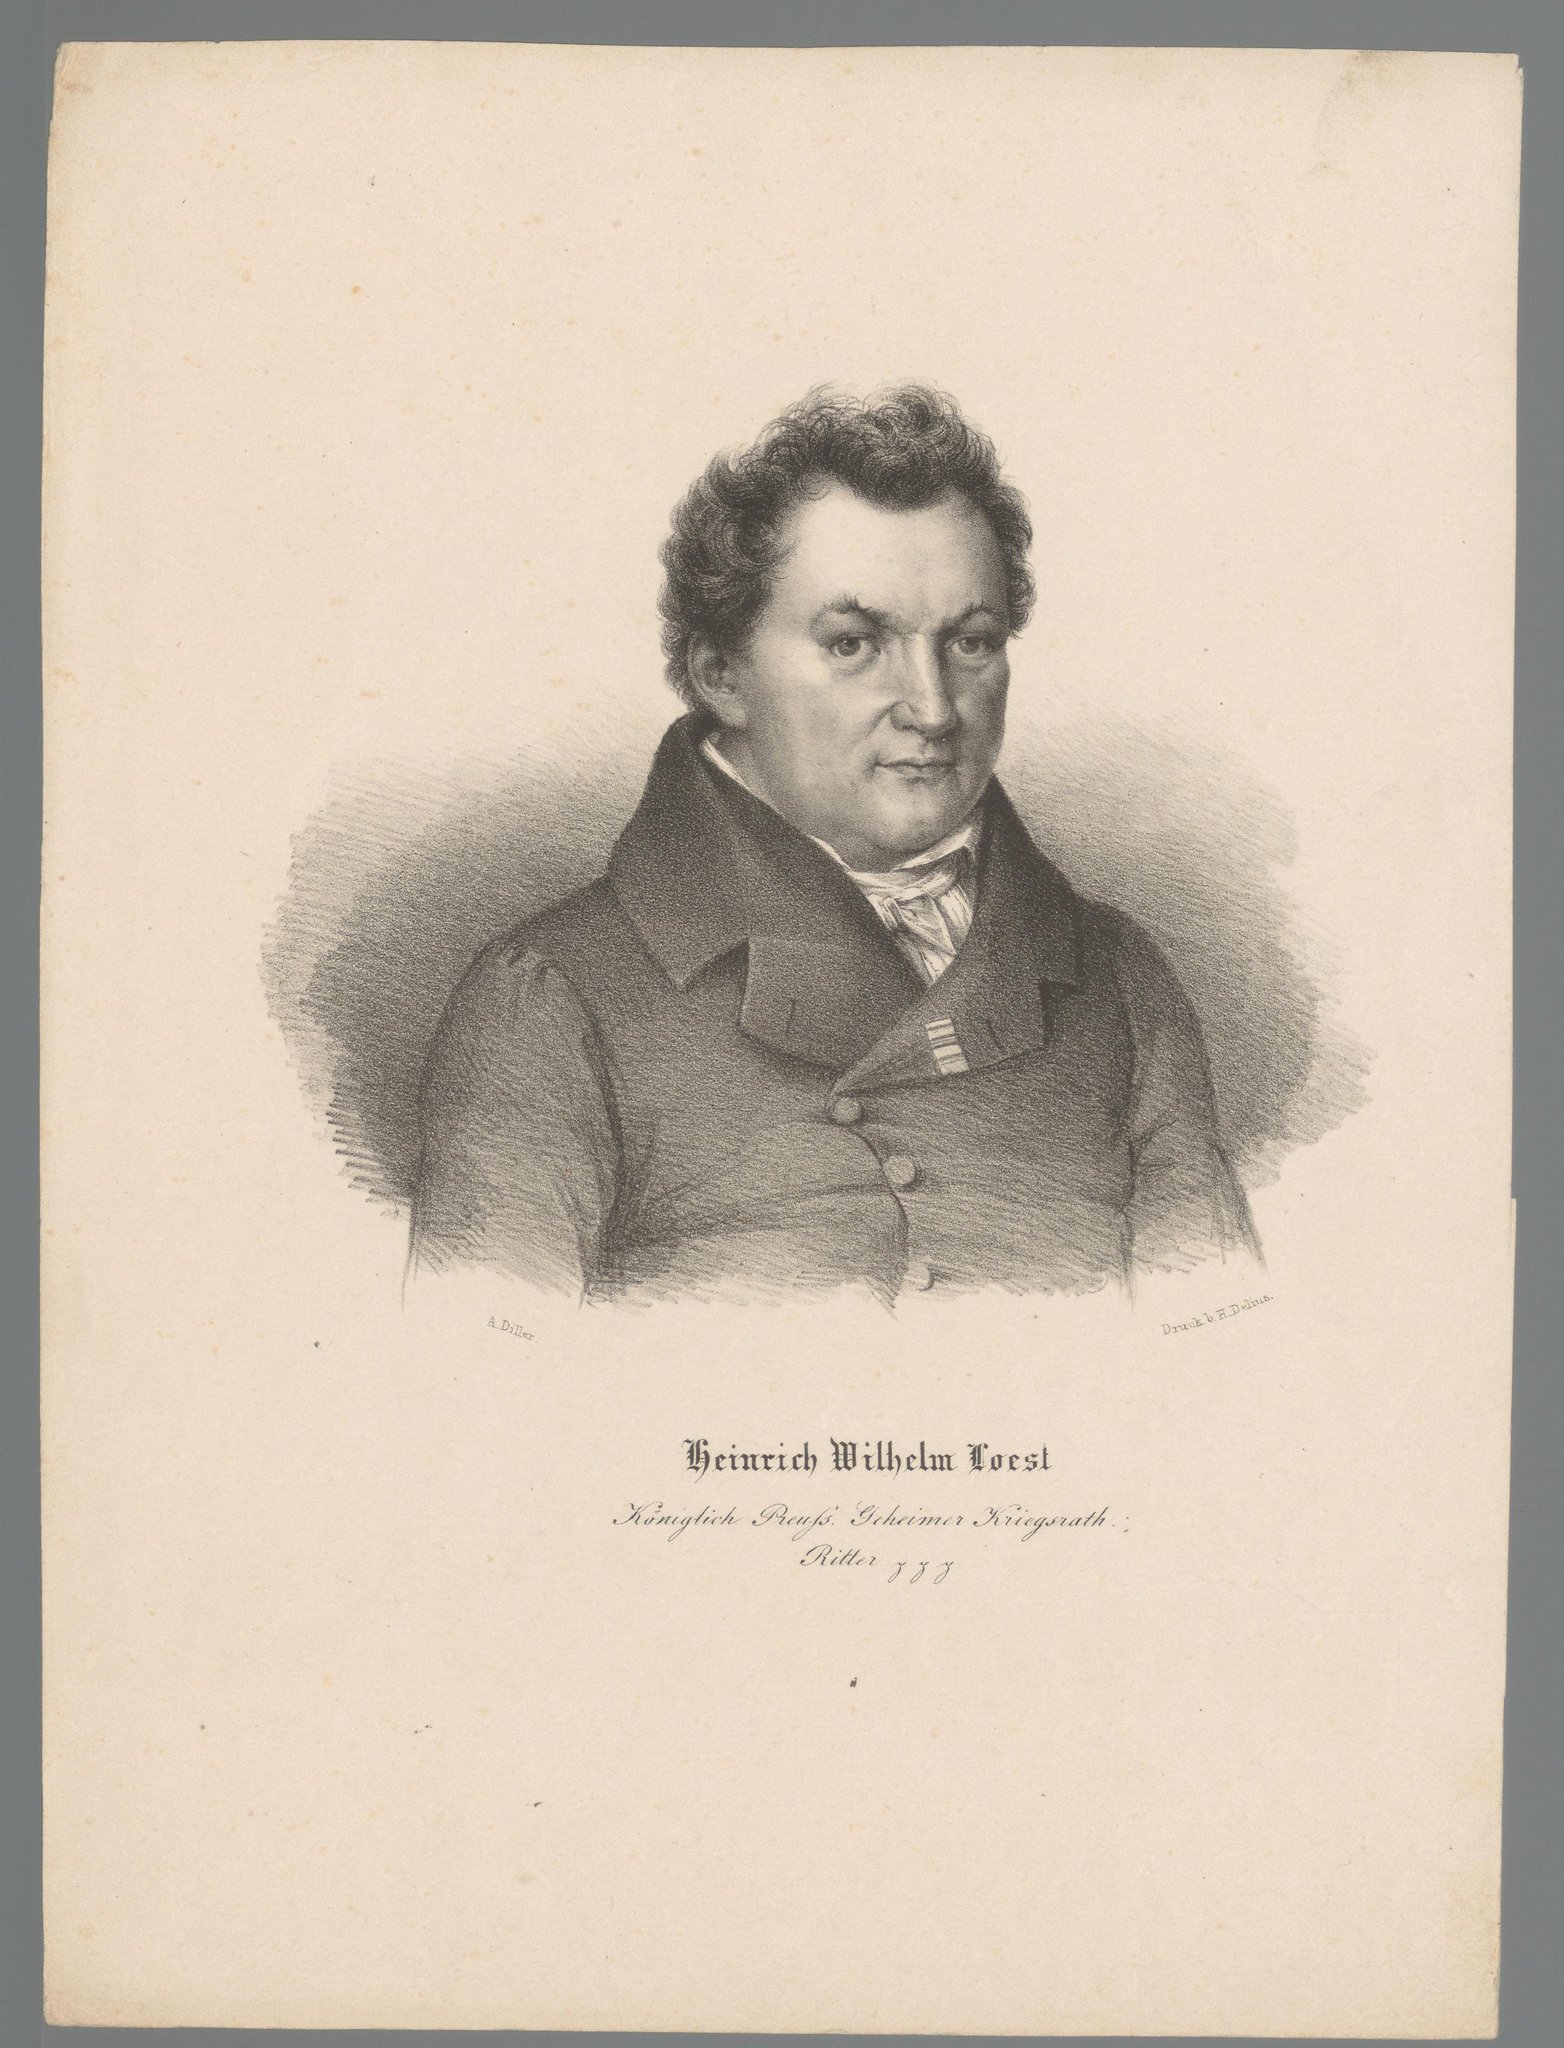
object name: print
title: Heinrich Wilhelm Joest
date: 1820-1850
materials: paper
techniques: lithograph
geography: berlin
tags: adult man, historical persons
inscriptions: collector's mark: Lugt 2228